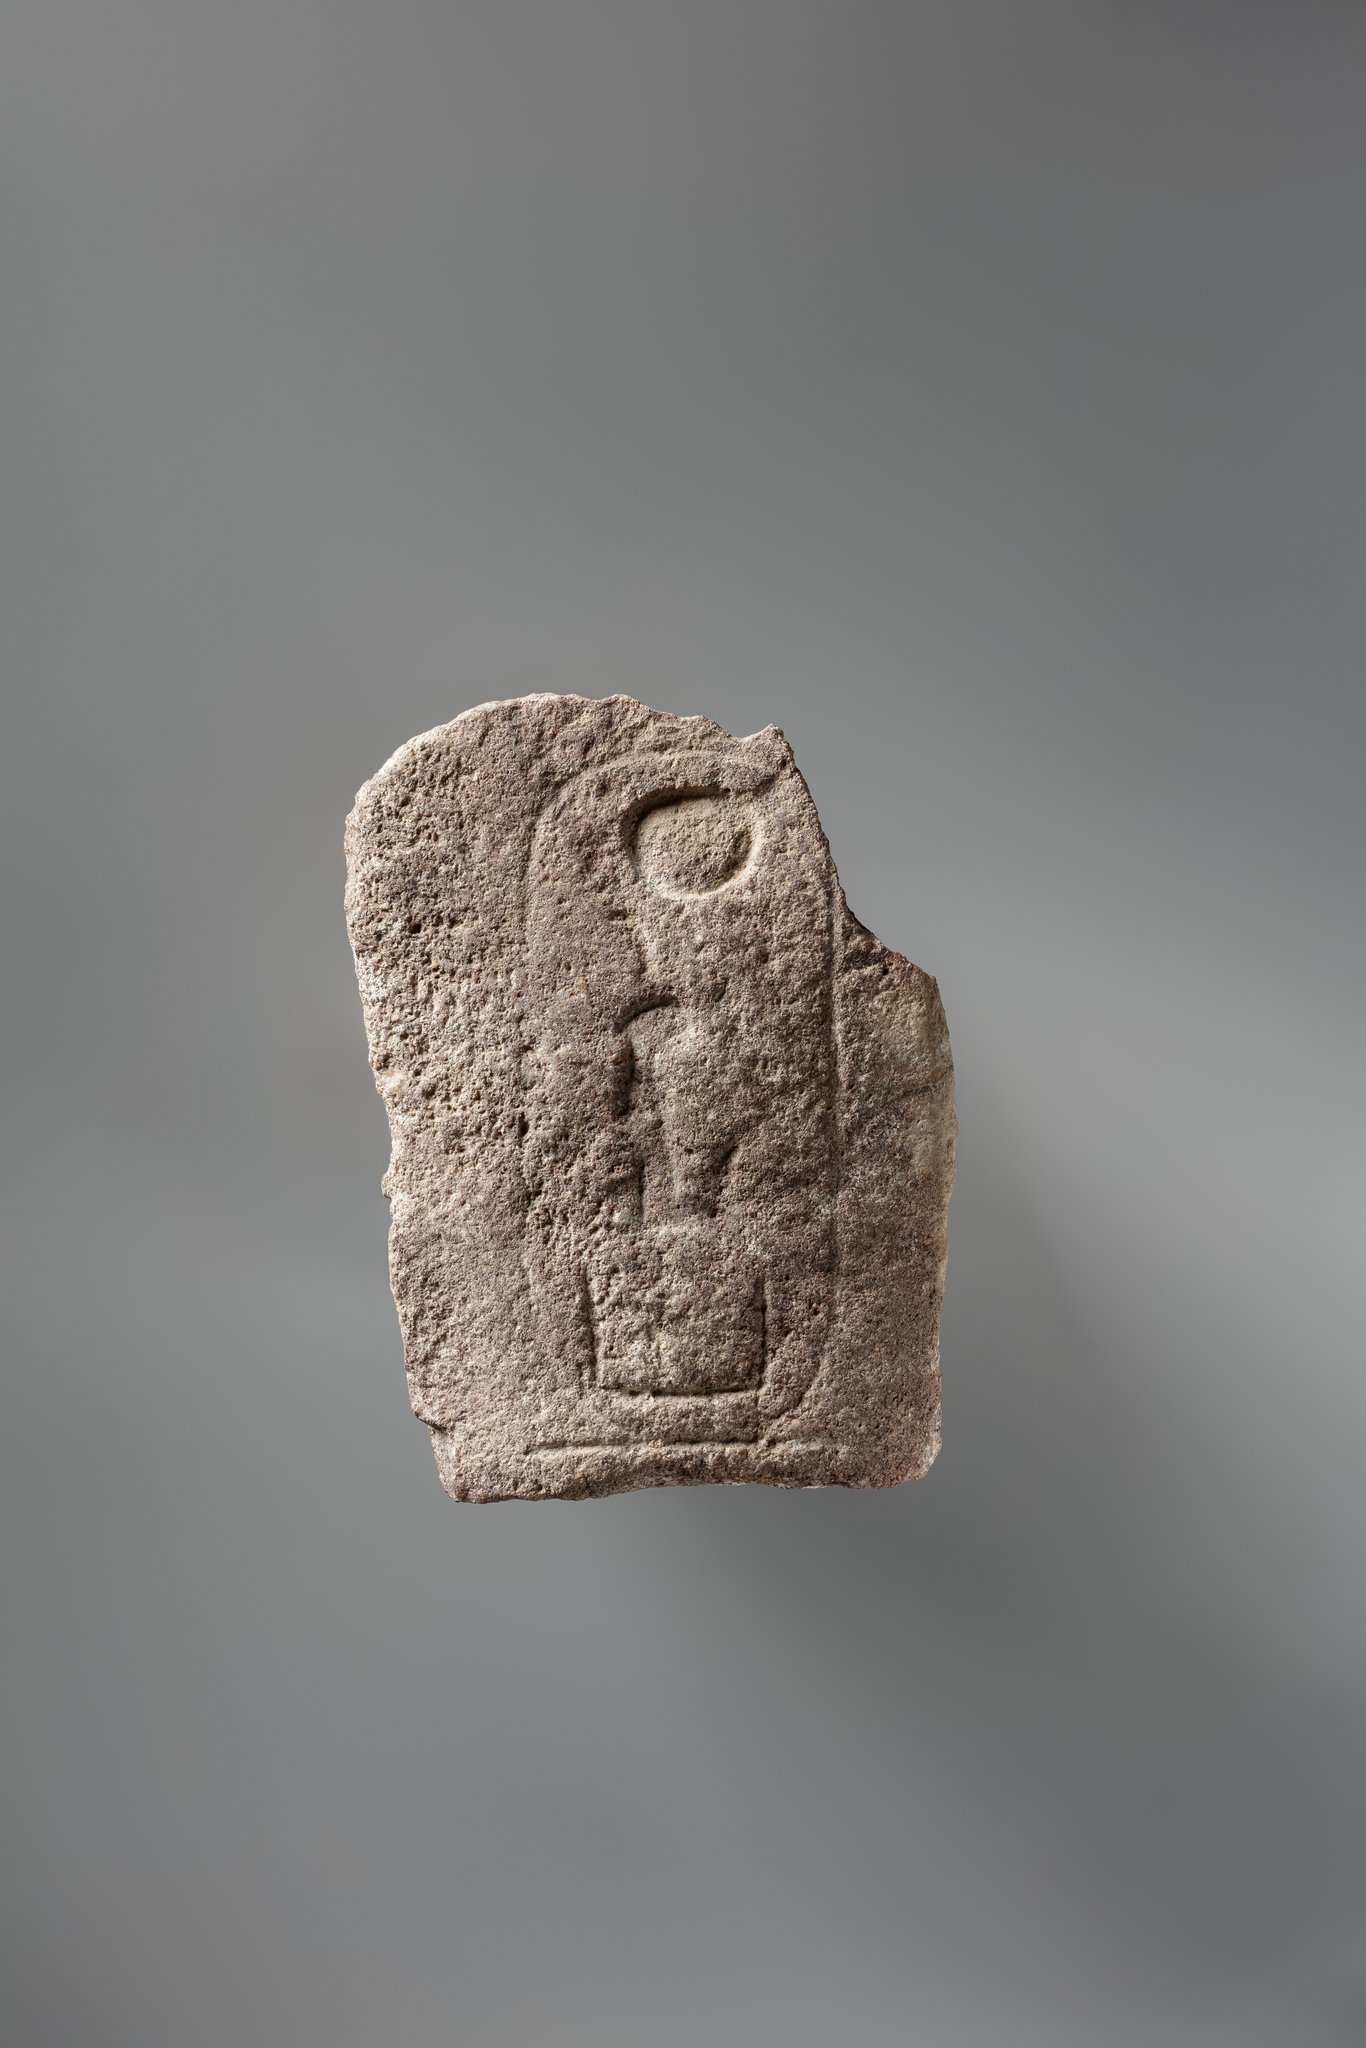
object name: inscribed stone, hatshepsut, maatkare, hieratic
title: Inscribed Stone from Hatshepsut's Valley Temple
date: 1479-1458 BCE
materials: quartzite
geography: egypt